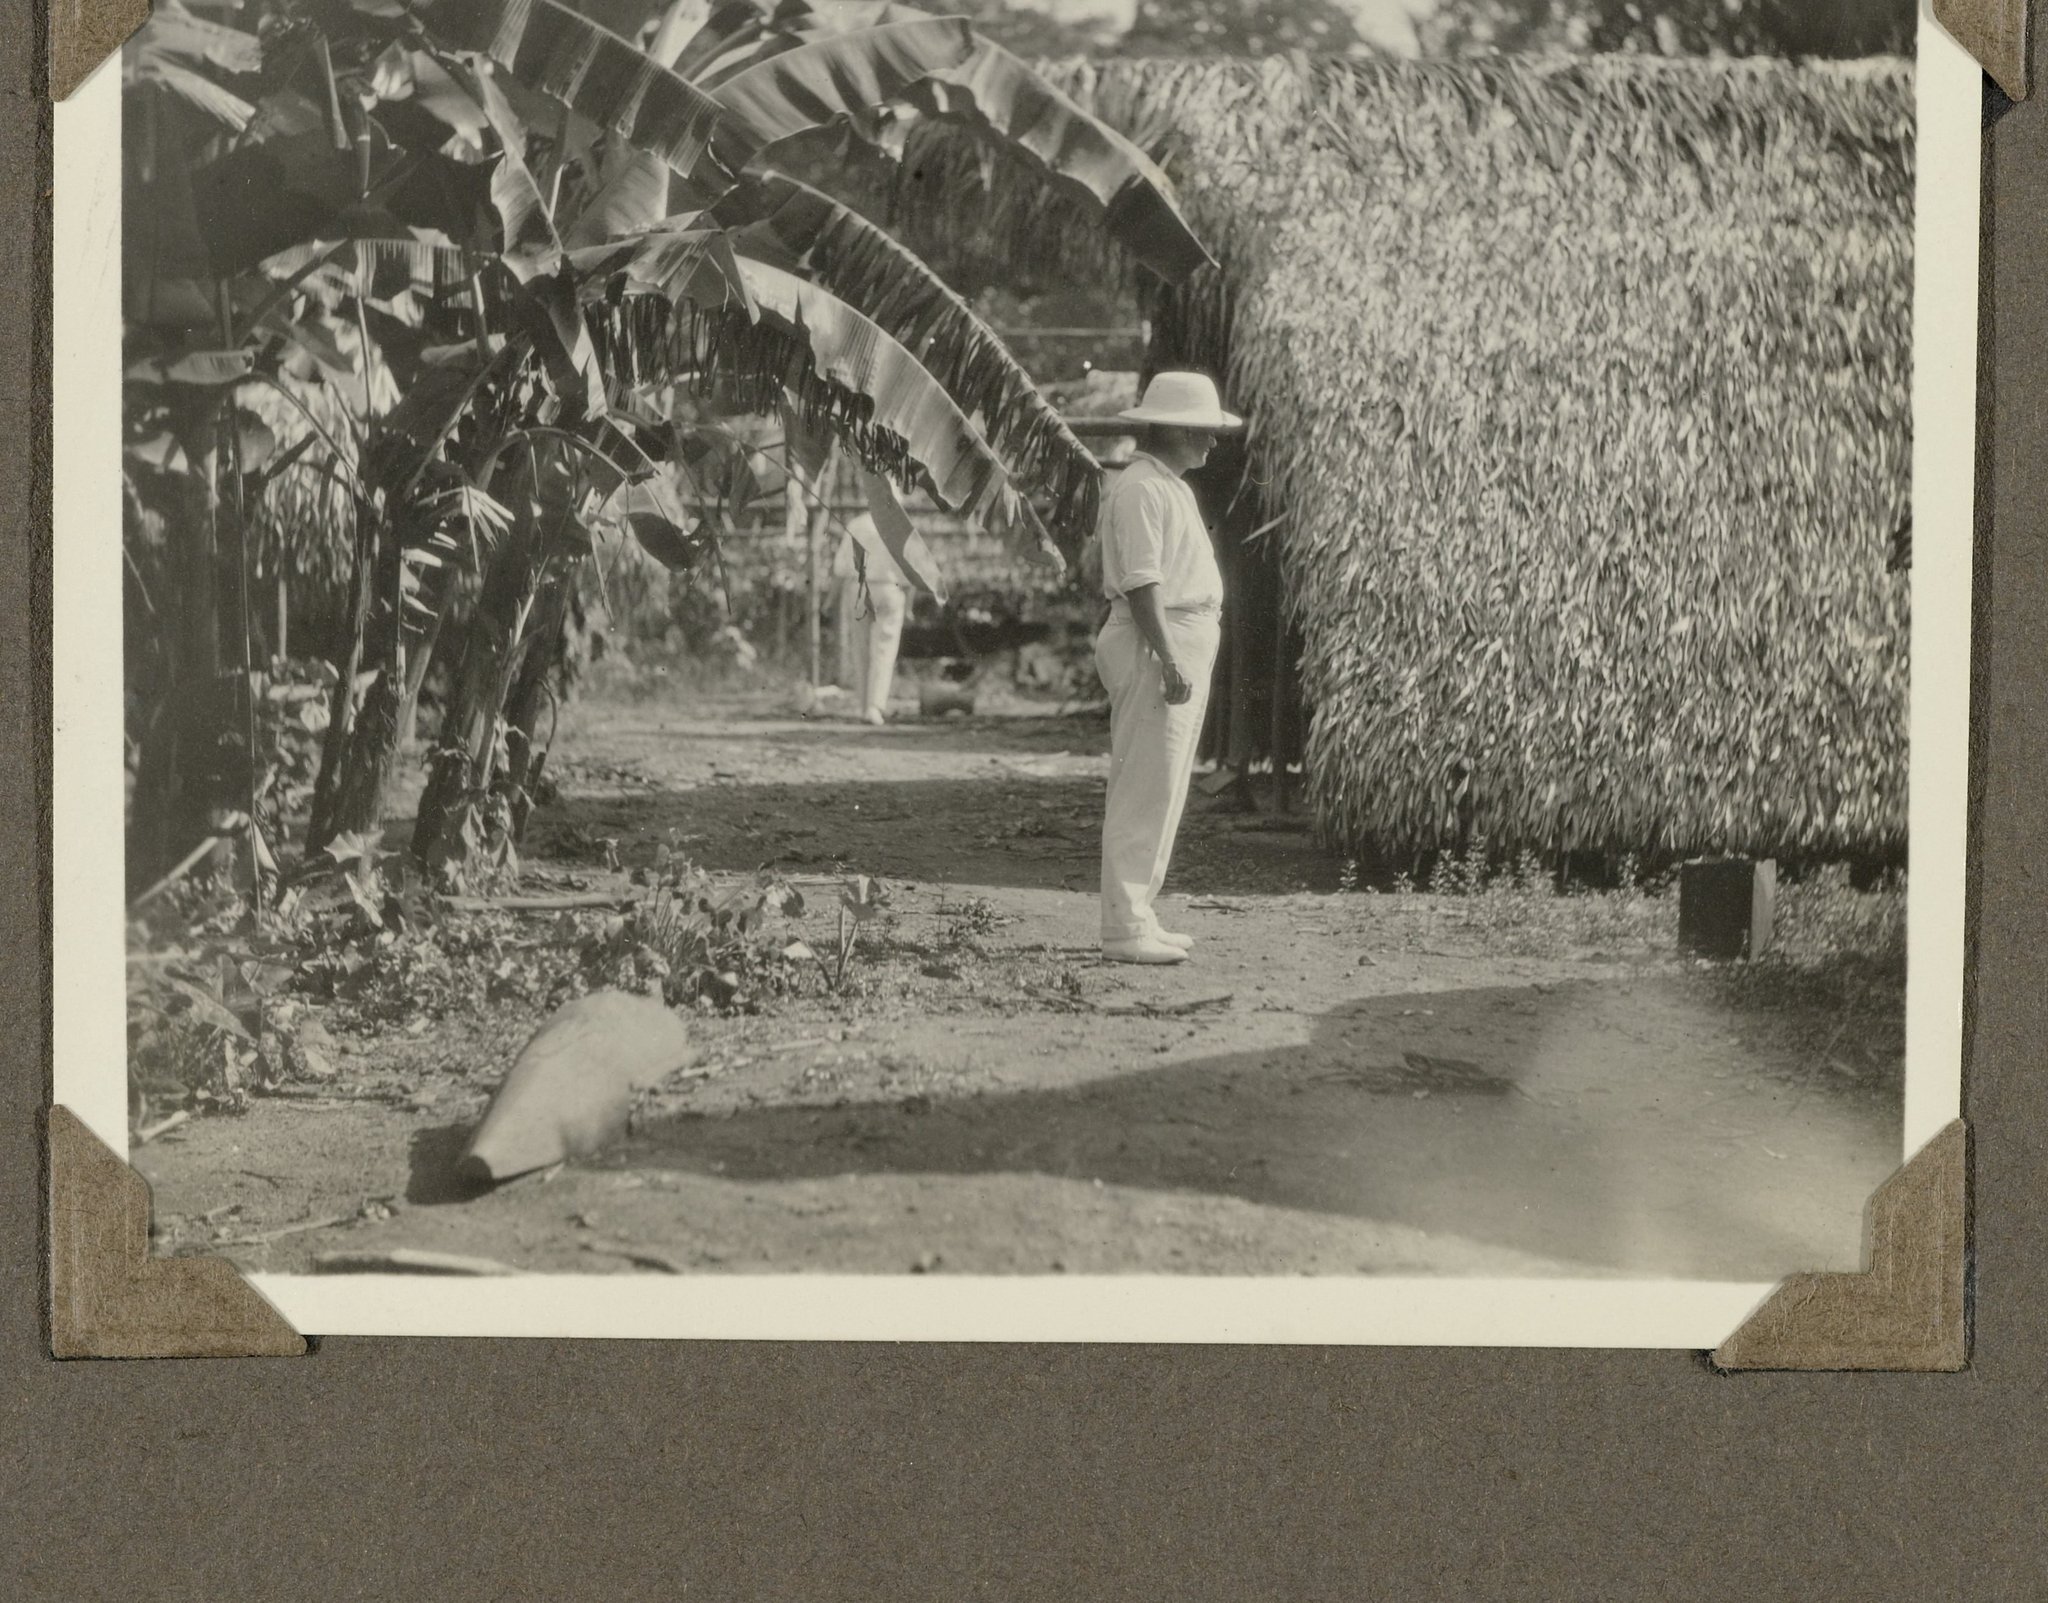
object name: photograph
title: Op bezoek in een dorp in Suriname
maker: Anonymous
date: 1925-1927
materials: photographic support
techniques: photography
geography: suriname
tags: landscapes in tropical and sub-tropical regions, suriname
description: Nederlanders op bezoek in een dorp in Suriname. Foto met hoekjes bevestigd op een bladzijde van een albumblad in het fotoalbum over de familie Jetten en het leven en werken in de mijnstad Moengo in Suriname rond 1927.